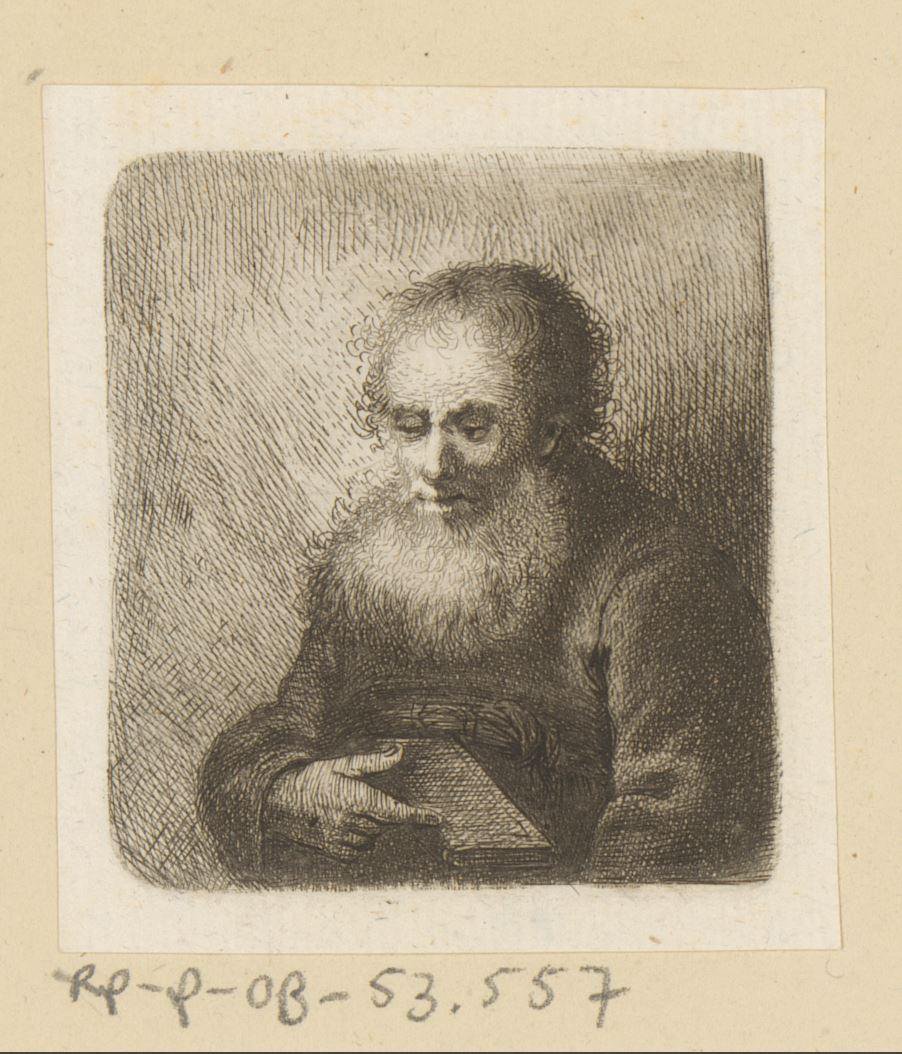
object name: print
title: Oude man met baard en boek in de hand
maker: johann andreas benjamin nothnagel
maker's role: print maker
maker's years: 1729-1804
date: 1739-1804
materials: paper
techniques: etching, intaglio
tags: old man, book, beard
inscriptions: collector's mark: Lugt 240